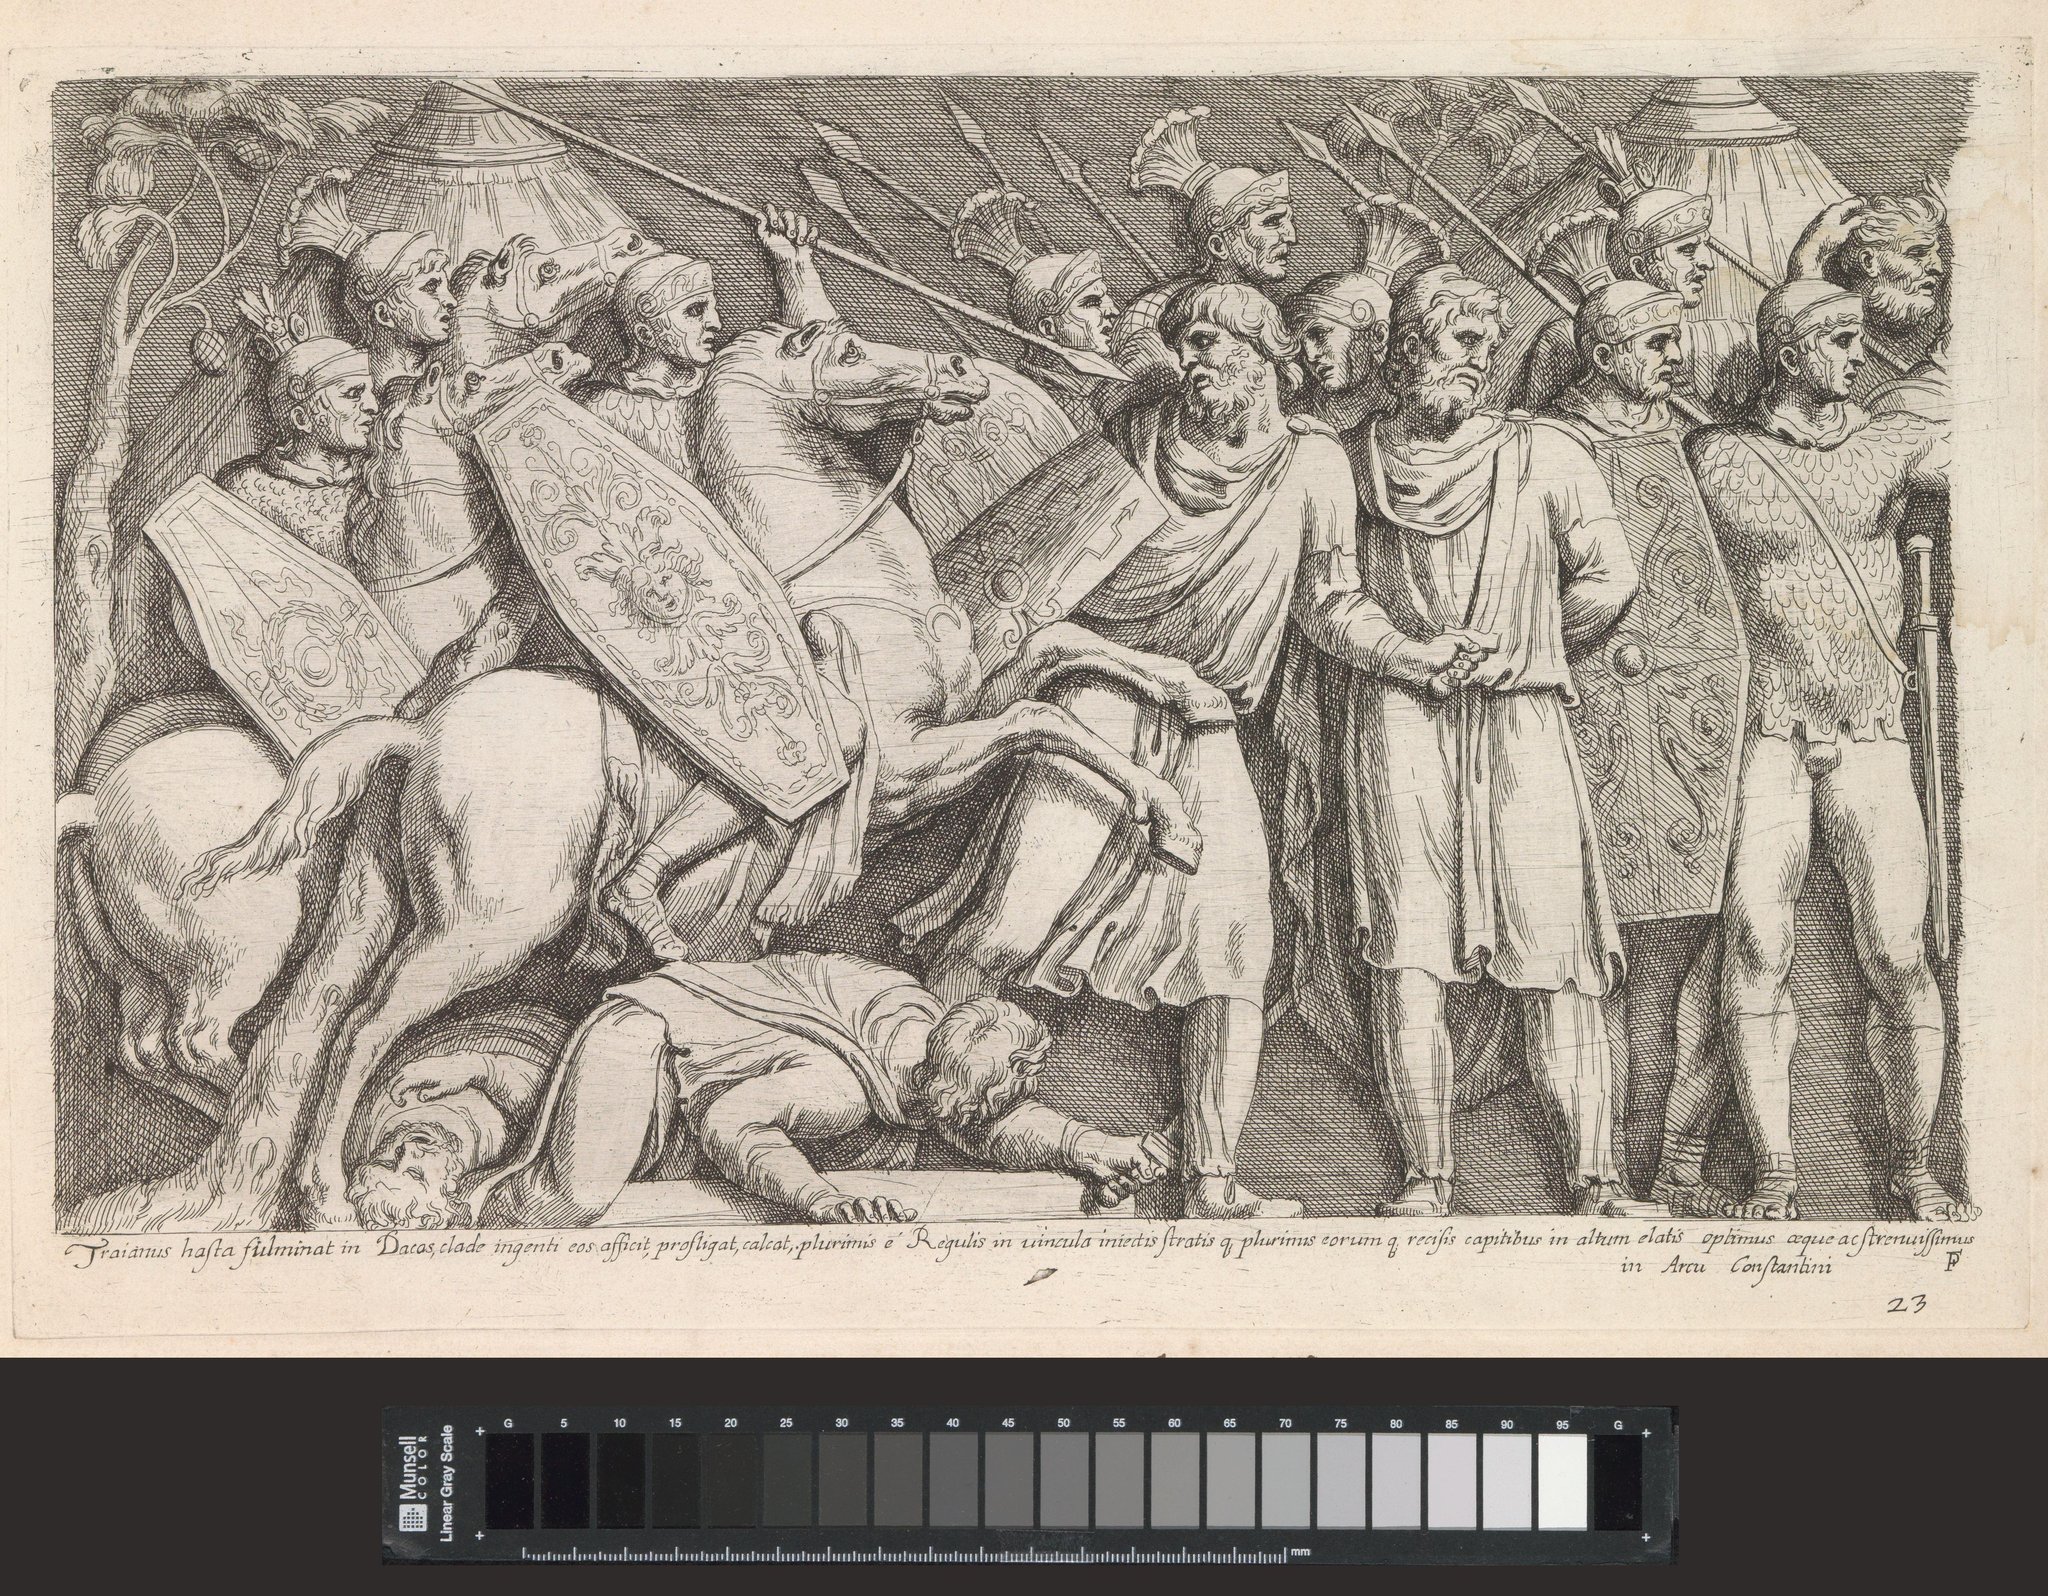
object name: album leaf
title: Romeinse gebeeldhouwde reliëfs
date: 1645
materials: paper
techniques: etching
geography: vatican city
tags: battle, piece of sculpture, reproduction of a piece of sculpture, the soldier; the soldier's life, the soldier; the soldier's life (+ cavalry, horsemen), arch of constantine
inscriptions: number: ‘50’, inscription: ‘Ende lib. No. 5. fol. 70. et 72/ 133/ lib. No. 8. tom. 1. No. 19. 20. 34. 358...’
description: Deze prent maakt deel uit van een reeks van 54 prenten (+ titelprent) naar antieke reliëfs. De nummering op de prenten loopt van 1 tot en met 50. Sommige prenten hebben dubbele nummers. Naar de reliëfs op de Boog van Constantijn te Rome.